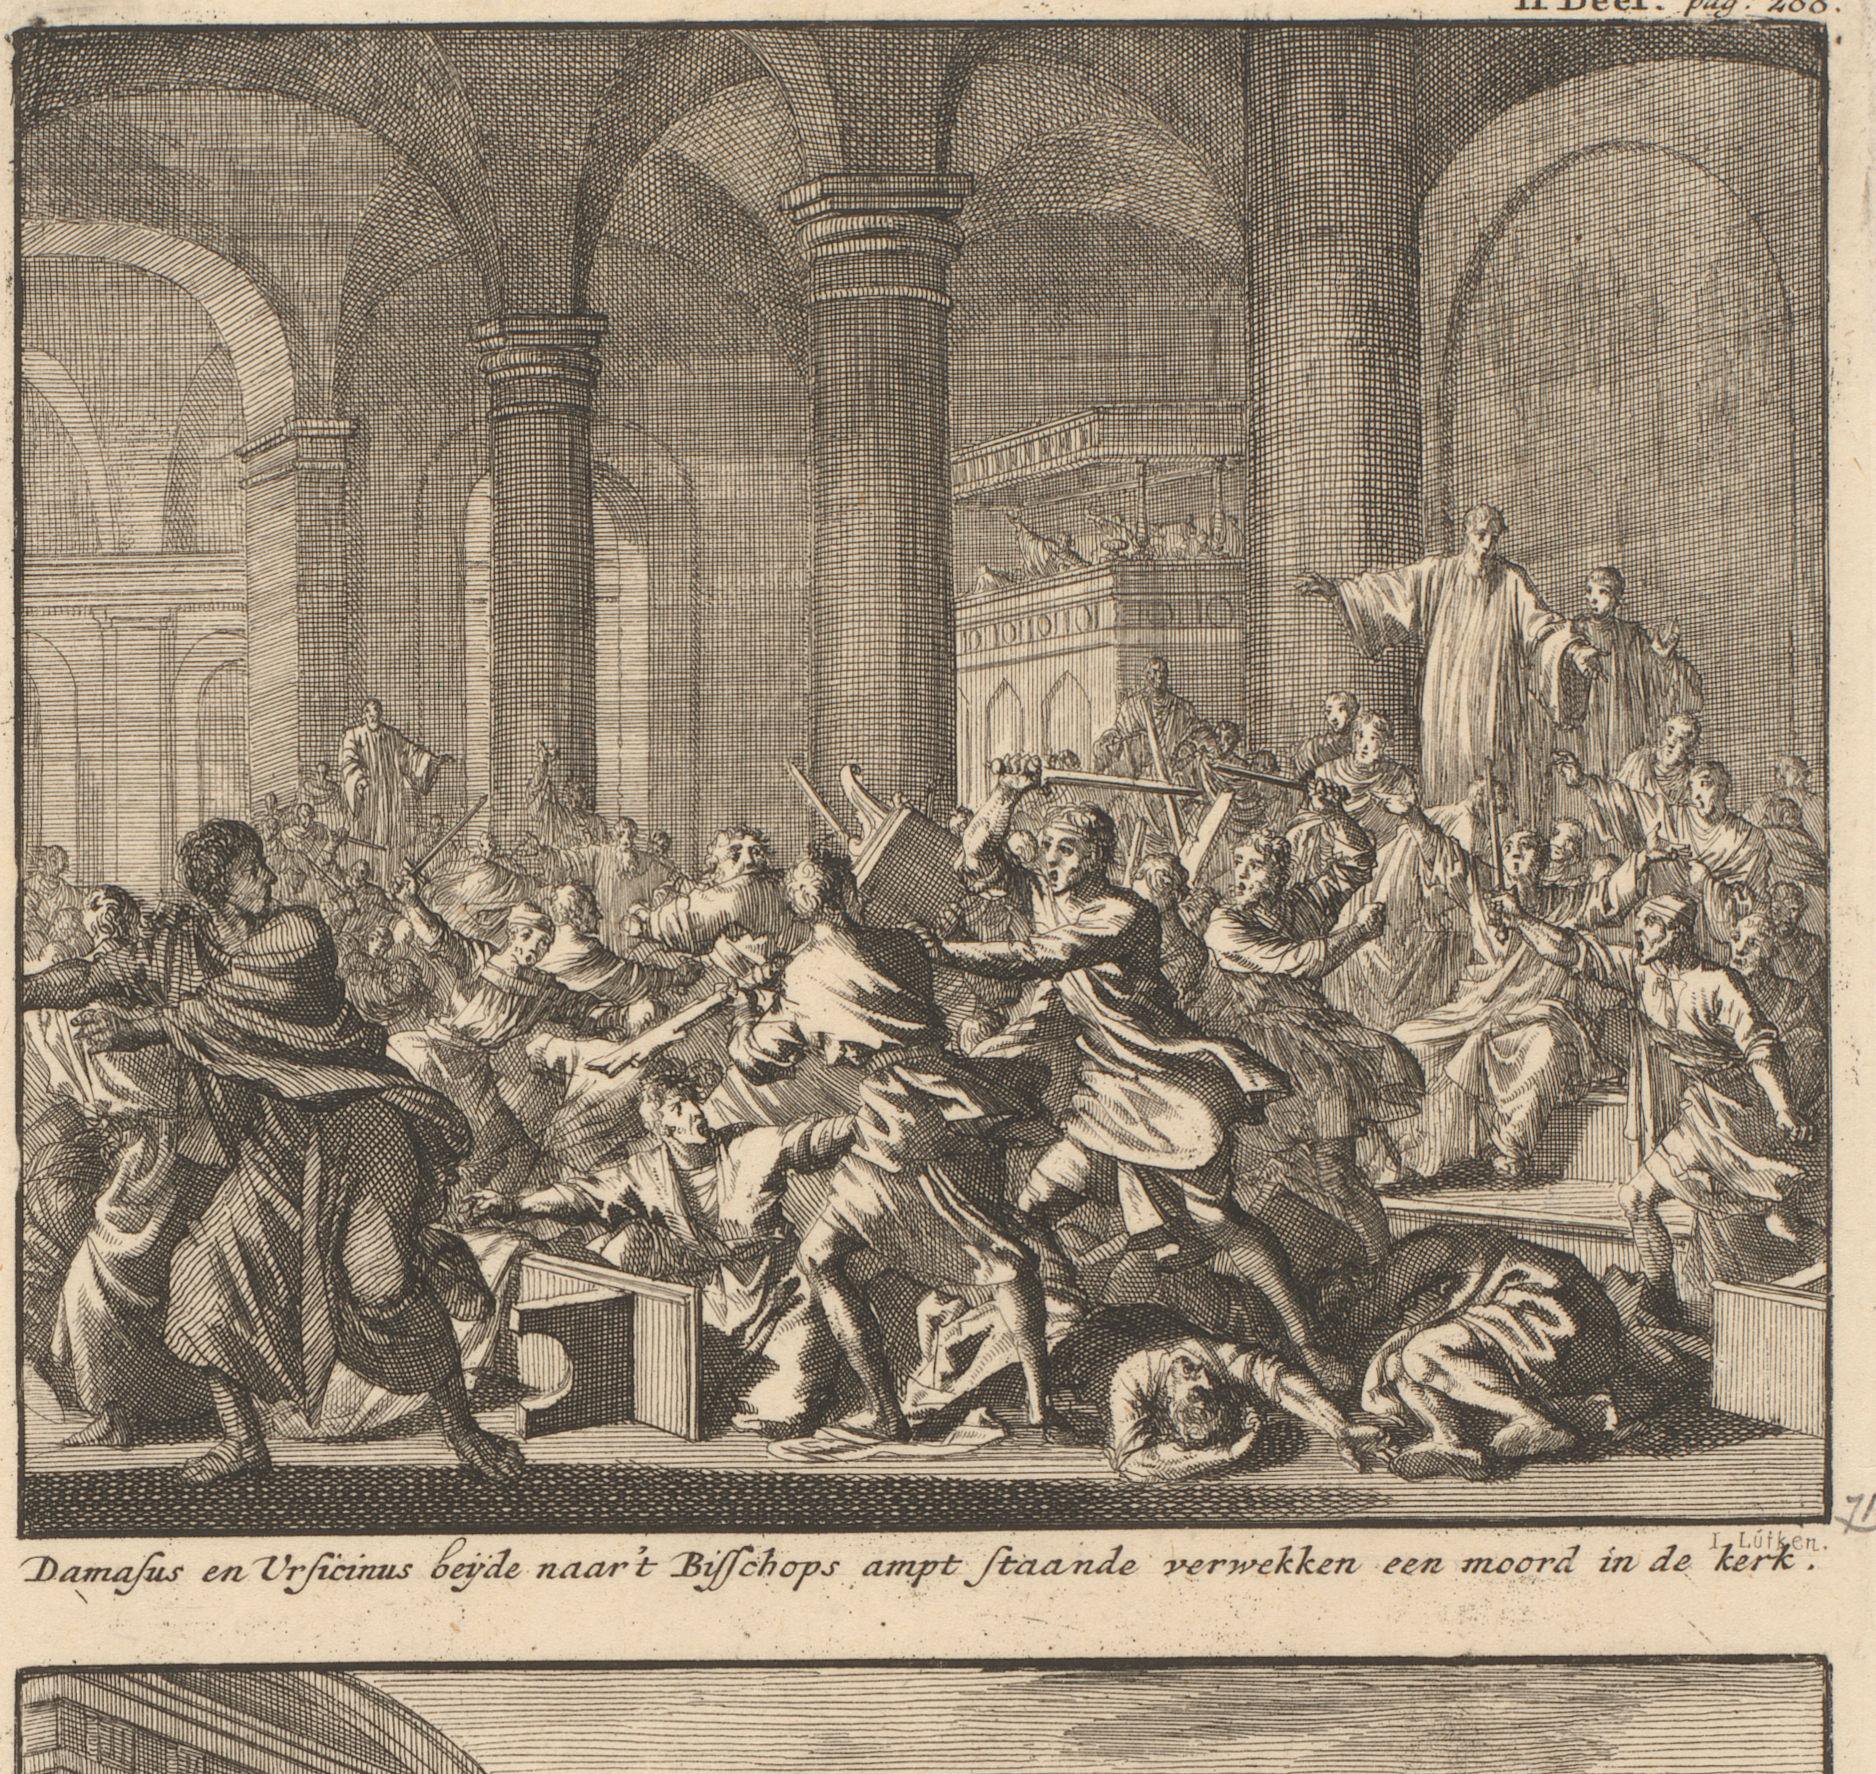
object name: book illustration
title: Damasus en Ursicinus beijde naar't Bisschops ampt staande verwekken een moord in de kerk / Symmachus en Laurentius willende elk Bisschop zyn, hitsen 't volk tot moord aan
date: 1701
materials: paper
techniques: etching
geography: amsterdam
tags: rome, installation of a pope, the early christian churches, e.g. armenians, copts, syrians, the martyr and deacon laurence of rome; possible attributes: book, censer, cross, dalmatic, gridiron, palm, purse (or cup with golden coins), interior of church, street-fights, riots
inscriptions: collector's mark: Lugt 2228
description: Twee voorstellingen op een plaat. Boven: de bisschopsverkiezing van Damasus in een kathedraal. Op de voorgrond wordt gevochten tussen aanhangers van twee bisschoppen. op de achtergrond de bisschopskandidaten Damasus en Ursinus. Onder: op de voorgrond gevechten tussen aanhangers van paus Symmachus en tegenpaus Laurentius. Op de achtergrond de twee pauselijke kandidaten.